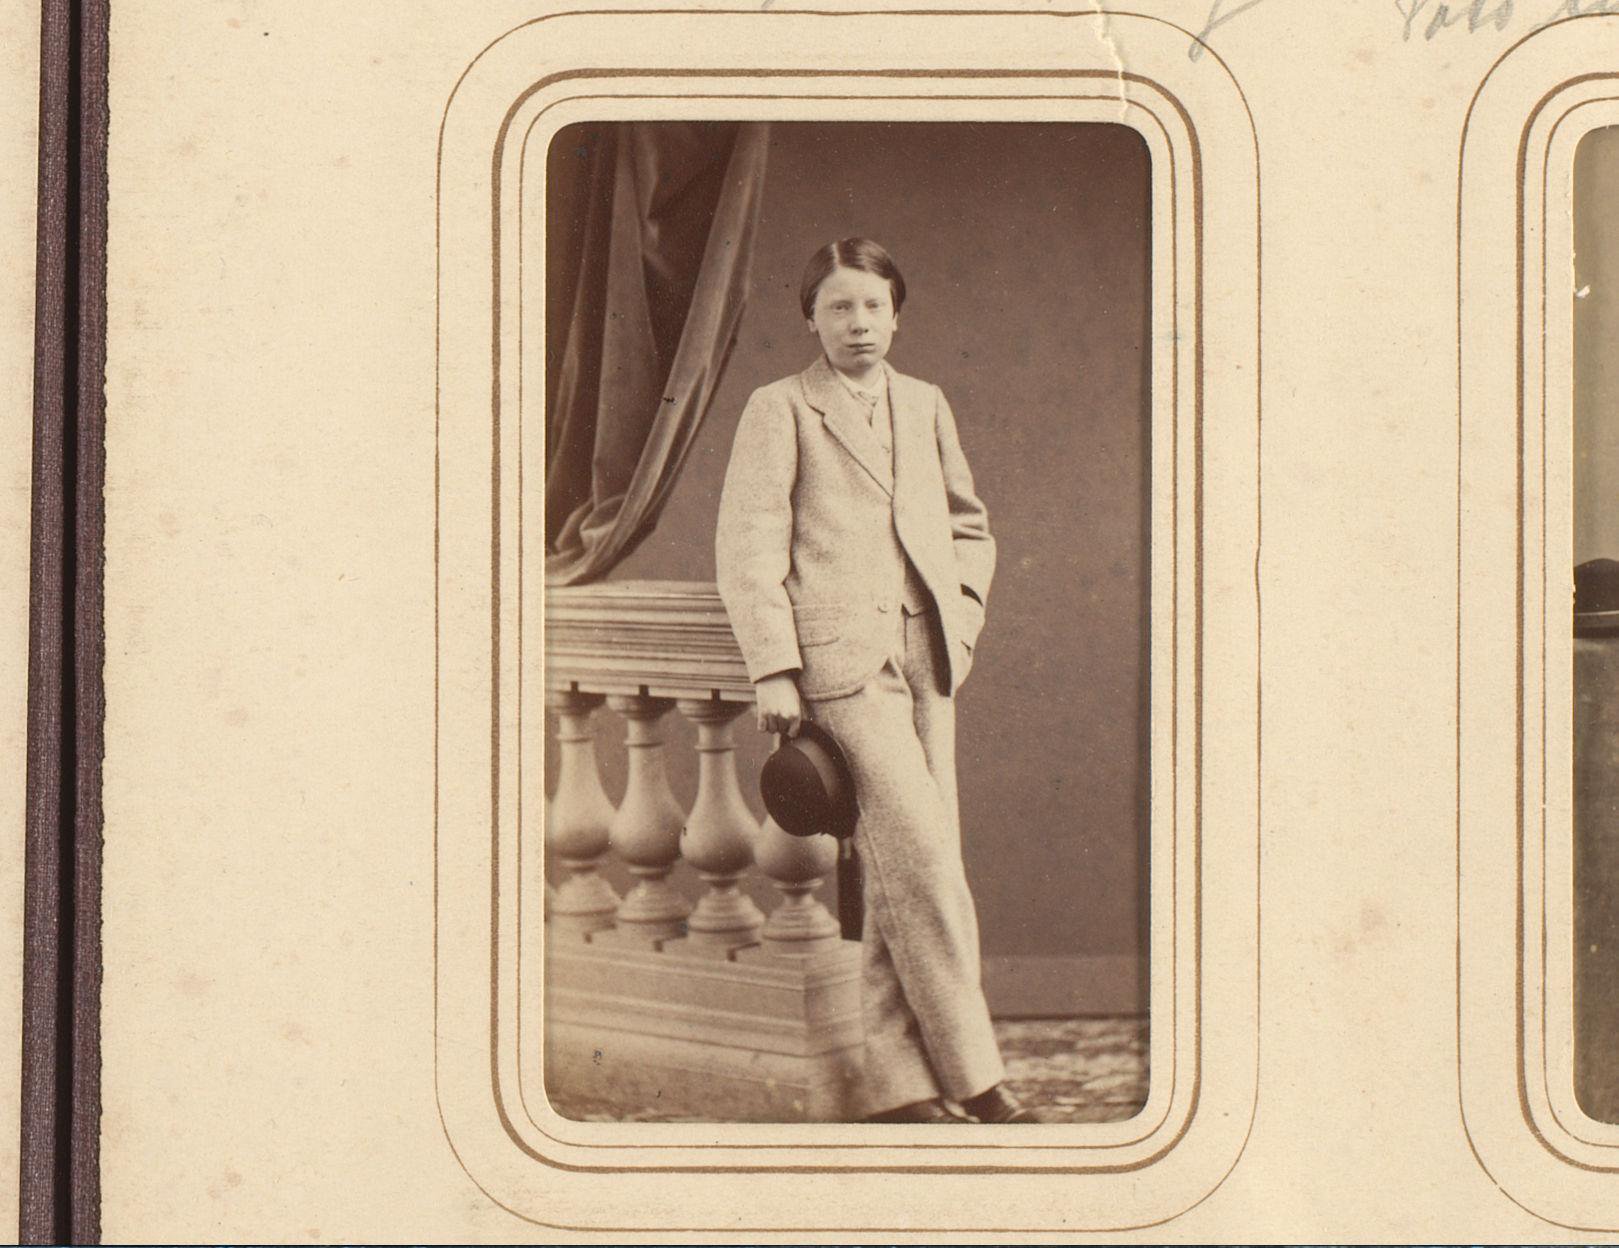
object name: carte de visite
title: Portret van prins Alexander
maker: maurits verveer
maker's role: painter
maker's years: 1817-1903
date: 1857-1865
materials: cardboard, photographic support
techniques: albumen print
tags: the hague, prince, youth, adolescent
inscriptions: inscription: ‘M. Verveer / Photographe / de L.L.M.M. le Roi et la Reine des Pays-Bas / 52, Zeestraat, 52. / Vis a vis du Willemspark / La Haye’, inscription: ‘M. Verveer Phot. de L.L.M.M. le Roi et la Reine.’